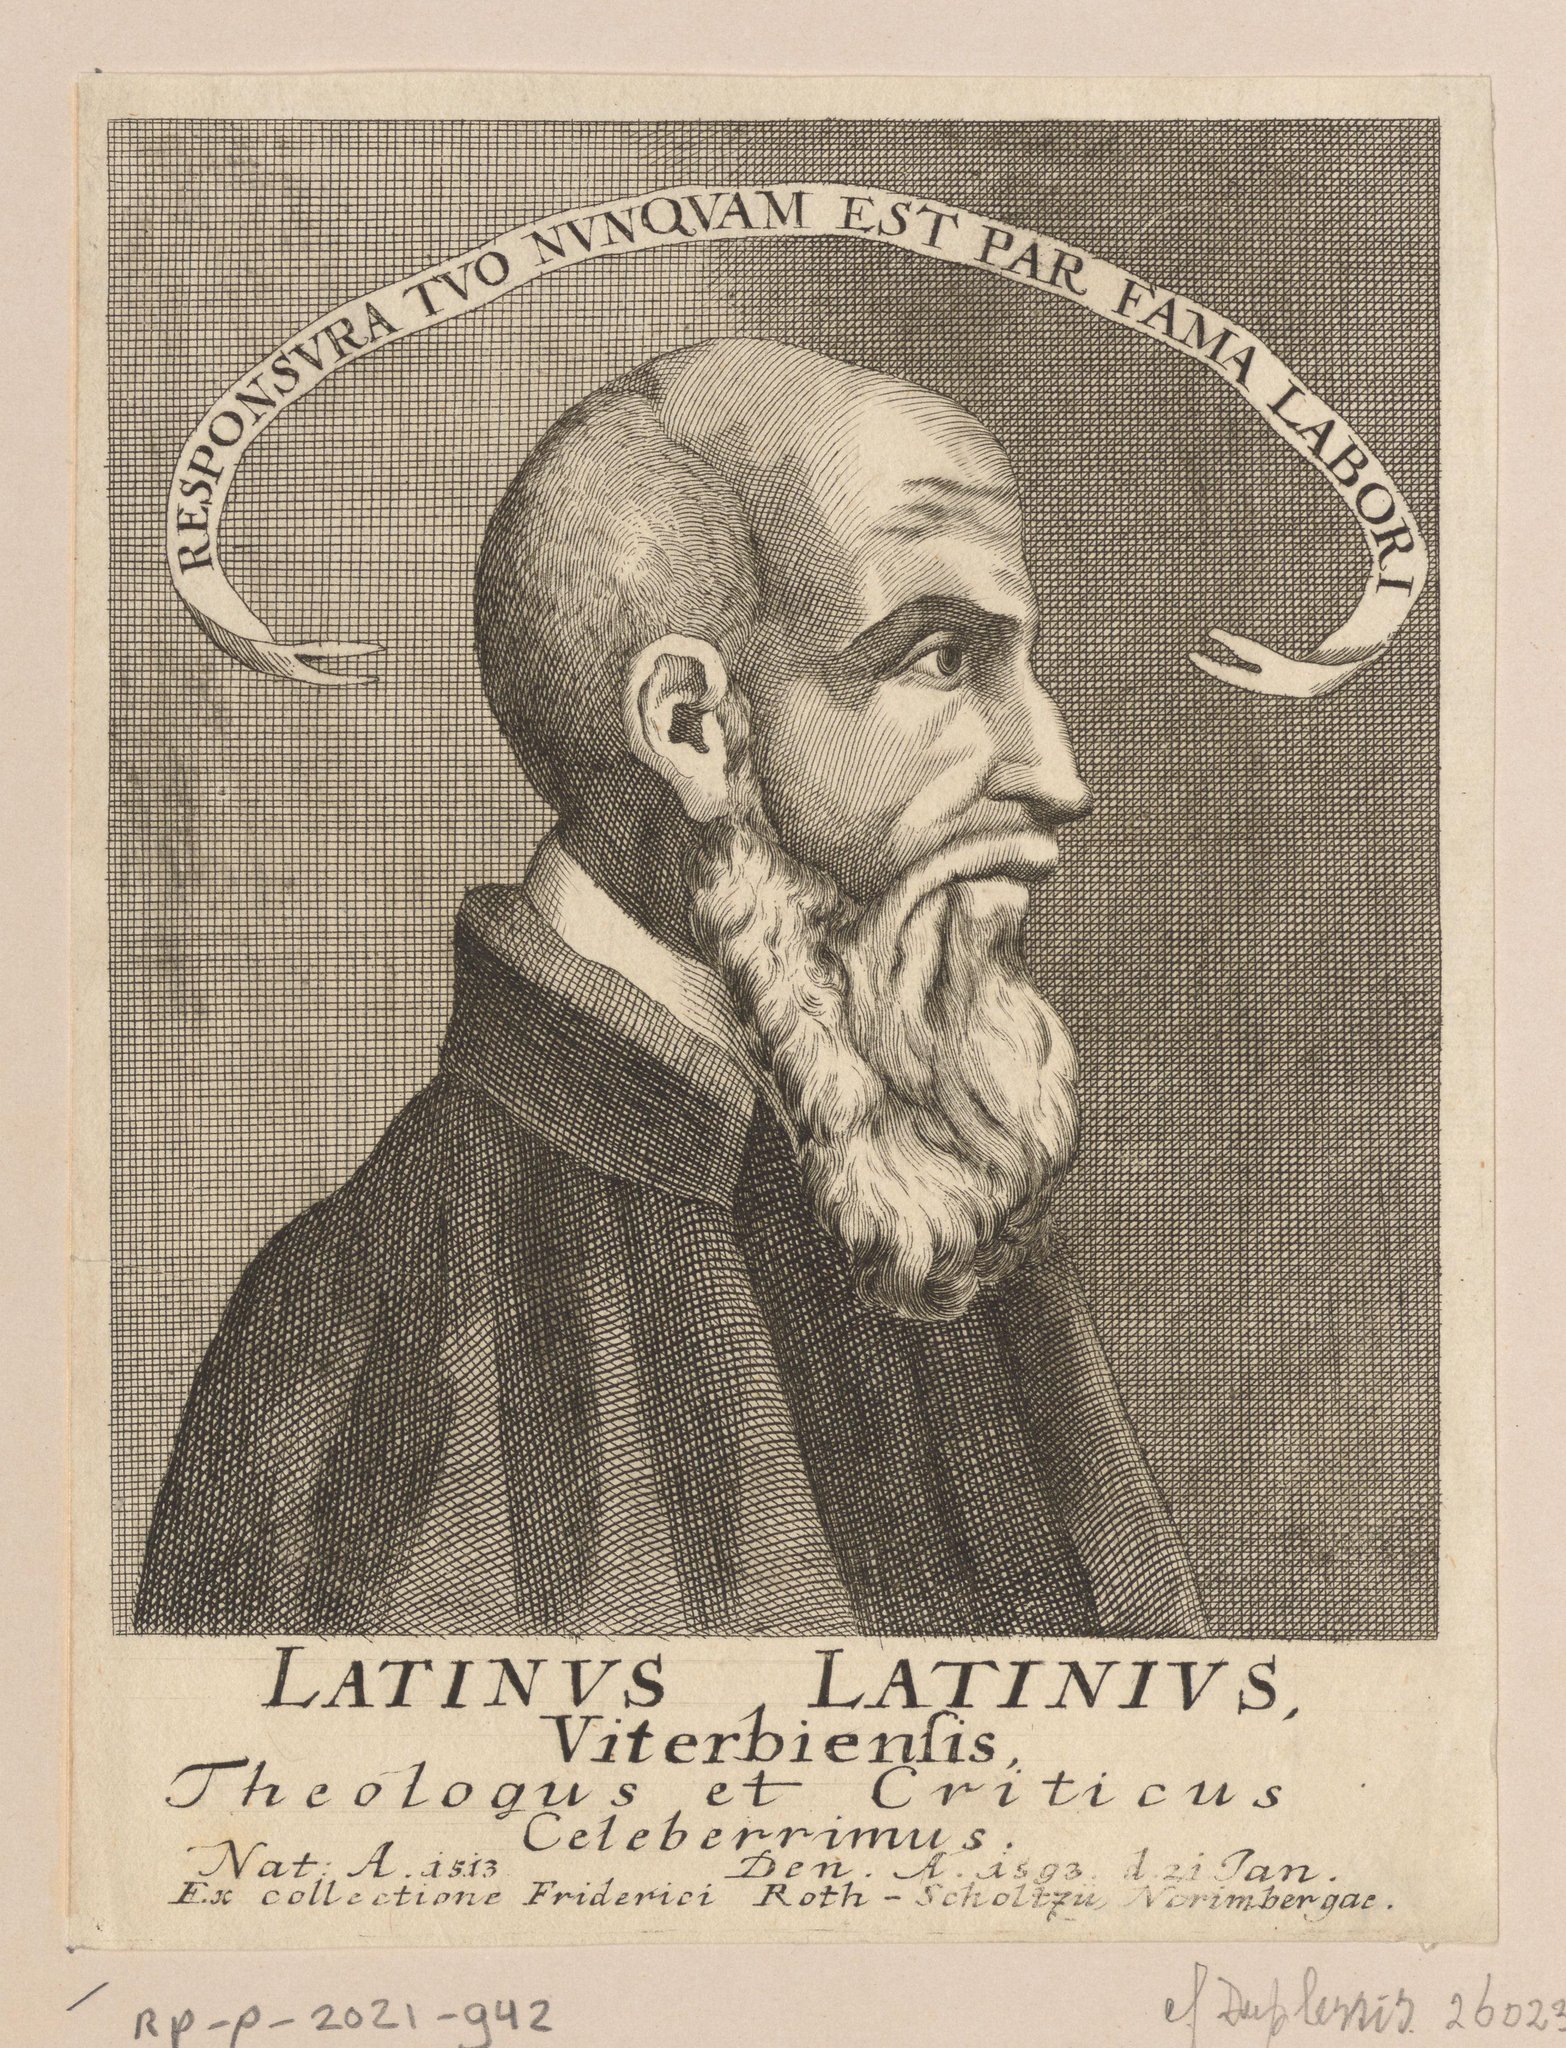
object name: print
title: Portret van Latino Latini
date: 1710-1736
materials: paper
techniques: engraving, etching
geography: germany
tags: archbishop, bishop, etc. (roman catholic), historical persons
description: Met Latijnse tekst onder het portret. Onder: Ex collectione Friderici Roth-Scholtzü, Norimbergae.